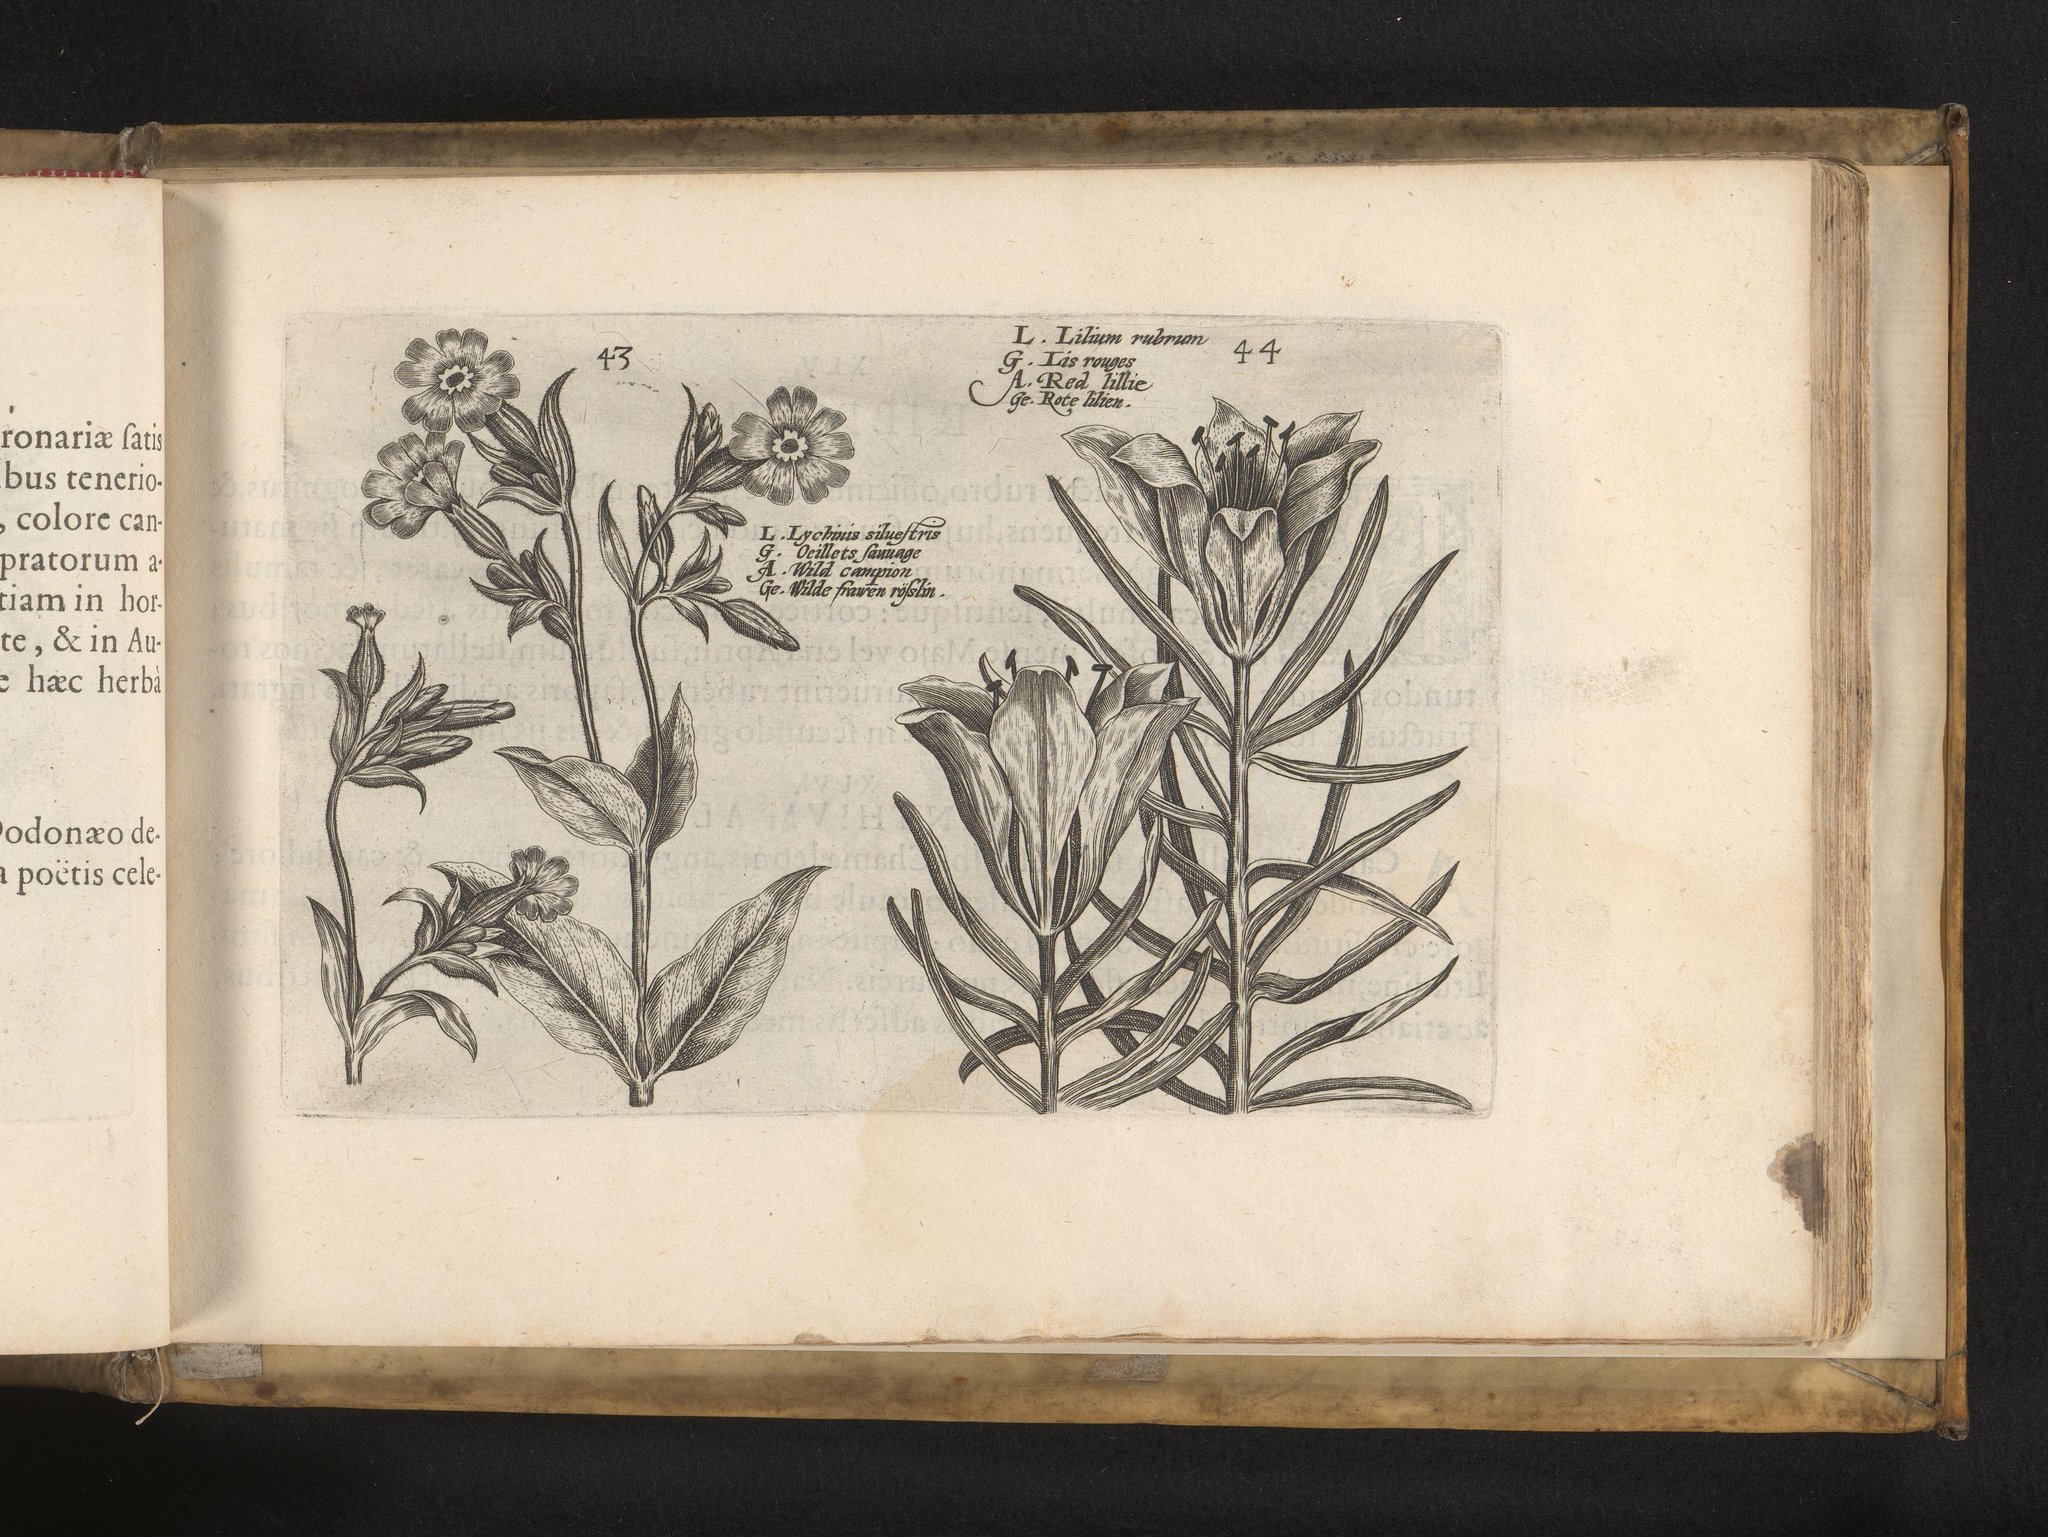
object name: book illustration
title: Bloementuin, het andere deel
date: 1617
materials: paper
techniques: engraving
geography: arnhem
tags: flowers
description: Prent uit: Passe, Crispijn van de (II). Hortus floridus in quo rariorum & minus vulgarium florum icones ad vivam veramque formam. Arnhem: Johannes Janssonius, 1617.